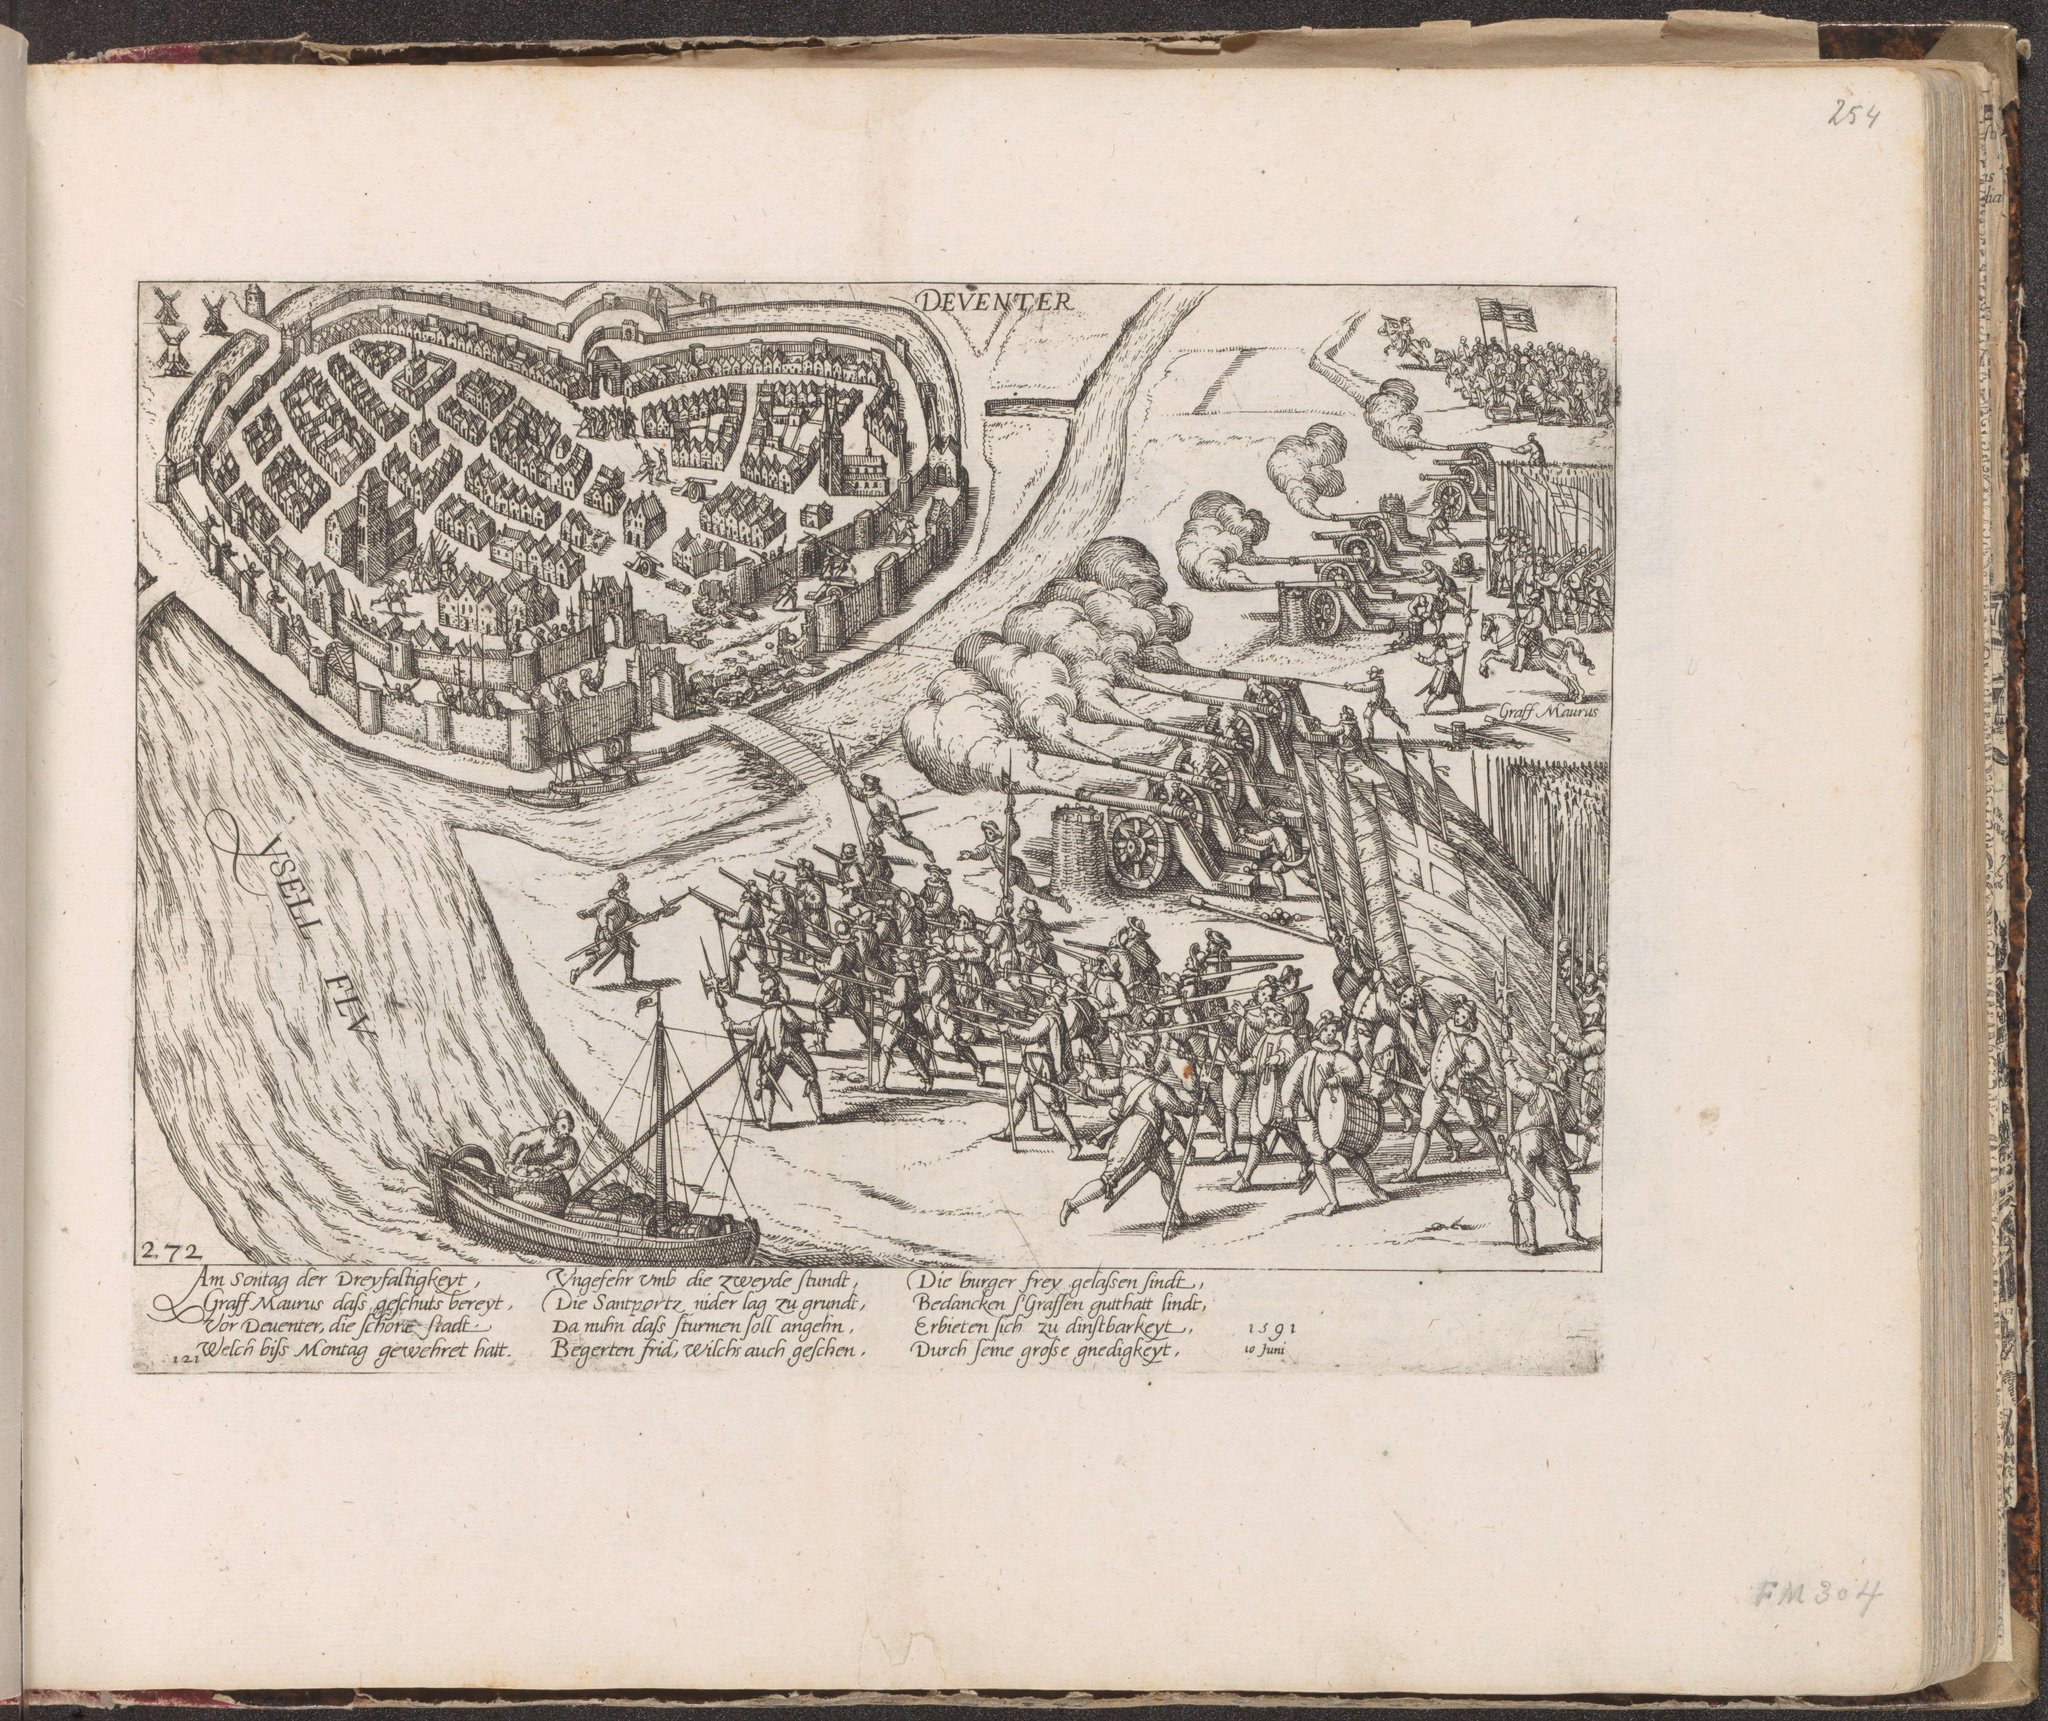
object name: print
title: Serie 10: Nederlandse en Buitenlandse Gebeurtenissen, 1587-1612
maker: frans hogenberg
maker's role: print maker, publisher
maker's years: 1538-1590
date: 1591-1593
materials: paper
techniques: etching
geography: cologne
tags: siege, position war, deventer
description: Inname van Deventer door prins Maurits, 10 juni 1591. Het Staatse leger schiet een bres in de muur van de stad. Met onderschrift van 12 regels in het Duits. Linksonder genummerd: 272. De prent maakt deel uit van een album.